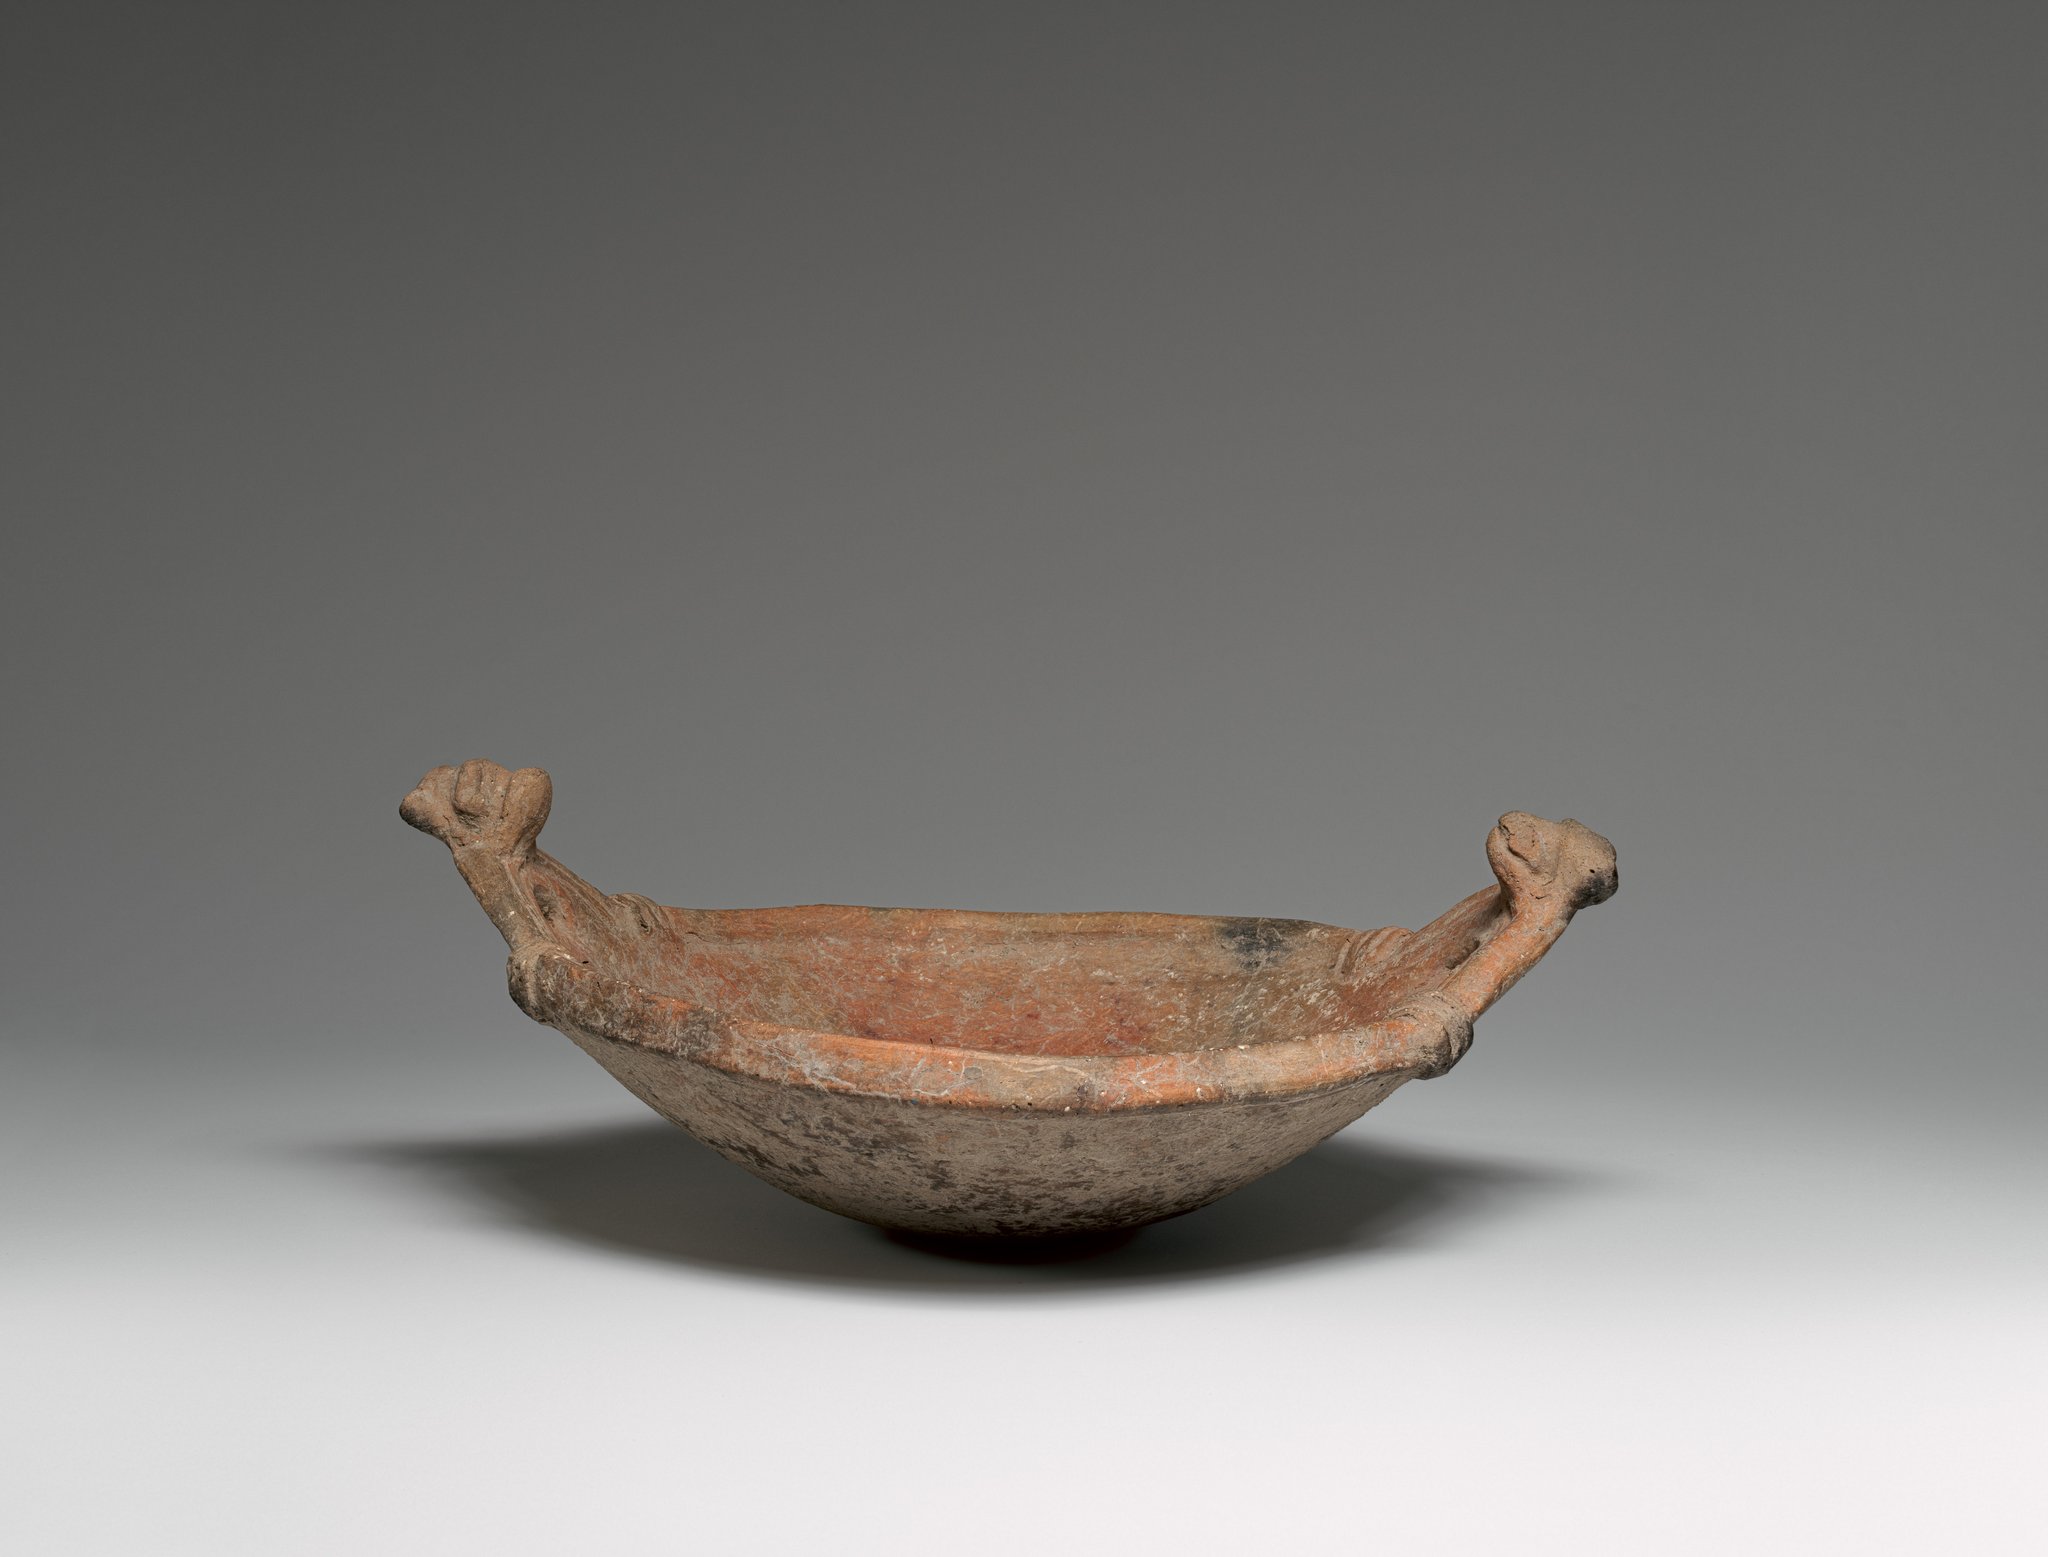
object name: bowl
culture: taíno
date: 1201-1500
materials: ceramic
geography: dominican republic